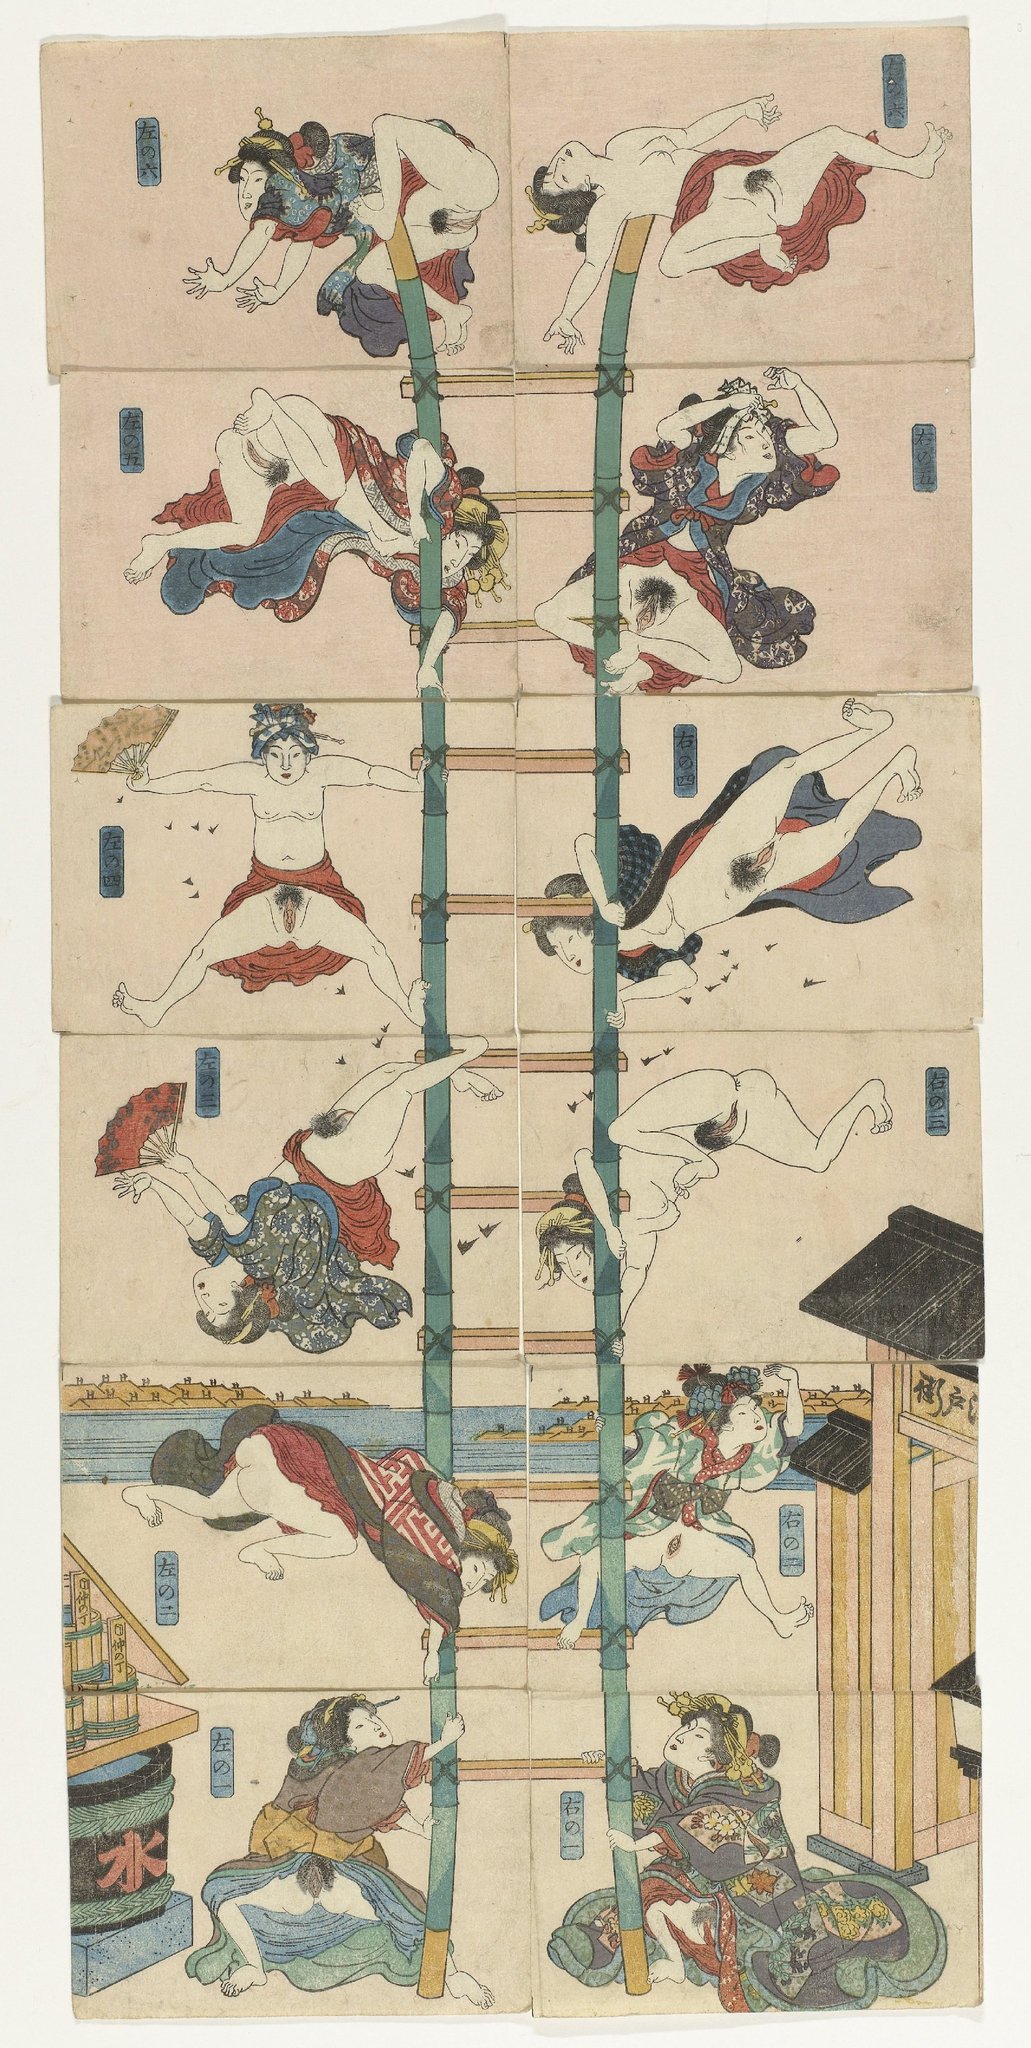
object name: print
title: Serie van twaalf koban Shunga met prostituées in de rol van acrobatische brandweerlieden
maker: utagawa kuniyoshi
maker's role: draughtsman, print maker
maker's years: 1798-1861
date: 1830-1835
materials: paper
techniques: woodcut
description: Serie van twaalf koban prenten met twaalf halfnaakte vrouwen die acrobatische toeren uithalen op een ladder. Per zes boven elkaar geplaatst vormen de twaalf genummerde bladen een parodie op soortgelijke voorstellingen van brandweerlieden die halsbrekende stunts uithalen. De opschriften op de emmers op de één na onderste prent links verwijzen naar de straat Nakanocho in het Yoshiwara district - de prostitutiewijk van Edo. Daaronder is het grote watervat weergegeven dat bij de poort van het Yoshiwara stond; de poort bevindt zich rechts. Mogelijk vormen de twaalf prentjes een kalender met verwijzingen naar de korte en lange maanden.